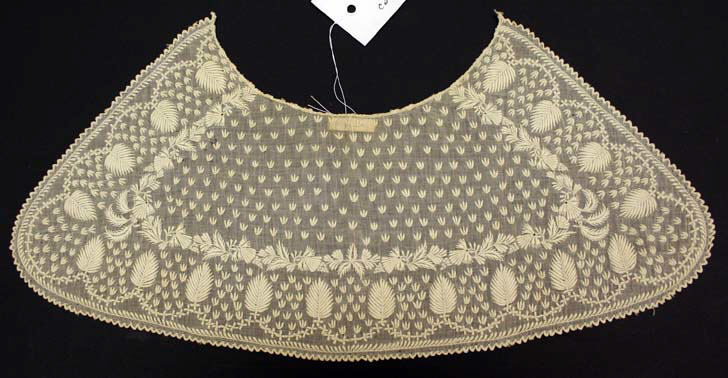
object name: collar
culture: american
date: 1834-1866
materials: cotton